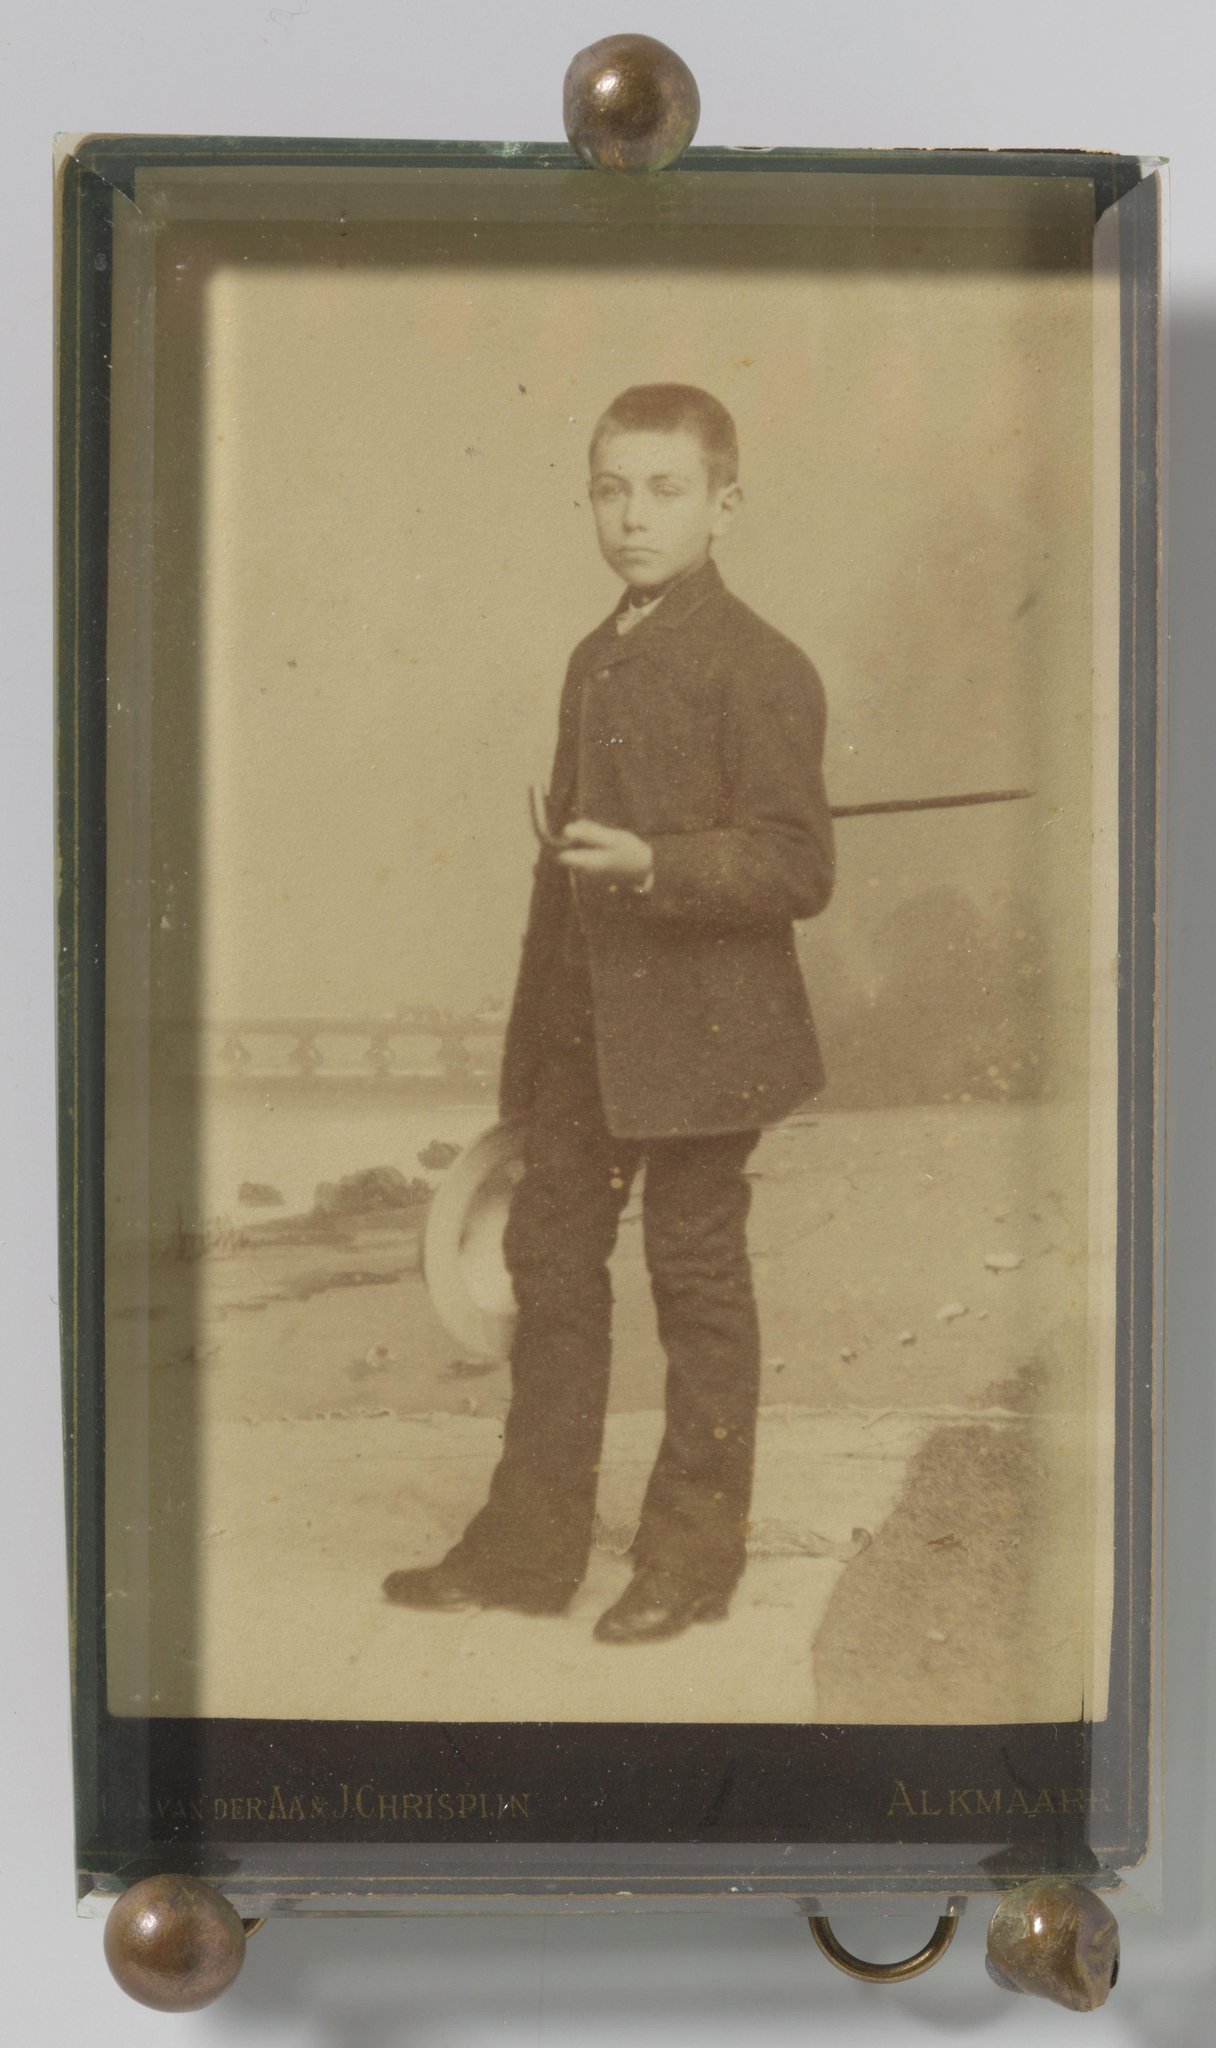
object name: frame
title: Portret van een onbekende jongen met hoed en wandelstok voor rivierdecor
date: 1884-1895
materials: cardboard, glass, metal, paper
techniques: albumen print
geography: alkmaar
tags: boy (child between toddler and youth), walking-stick, staff, anonymous historical person portrayed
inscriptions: address: ‘Verdronken Oord/ ALKMAAR/ HELDER/ Kanaalweg 99.’